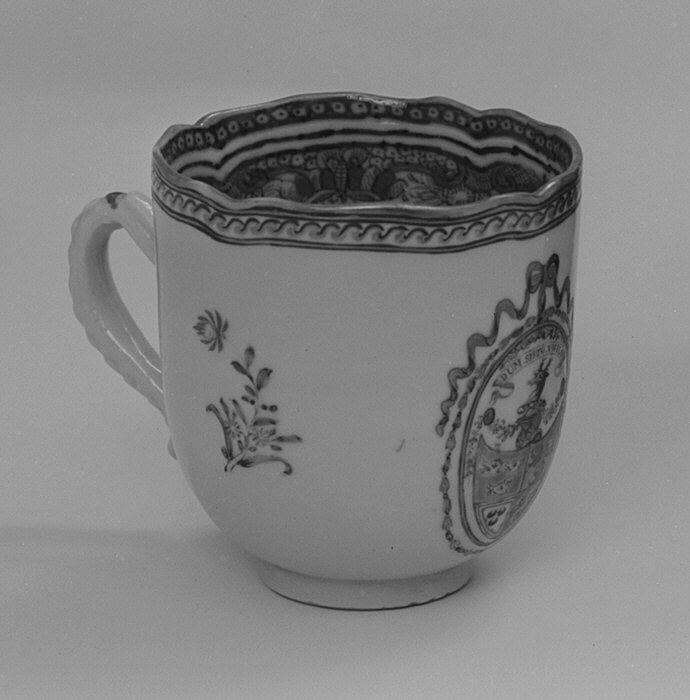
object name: teacup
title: Tea cup (part of a service)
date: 1770-1785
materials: hard paste porcelain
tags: coat of arms